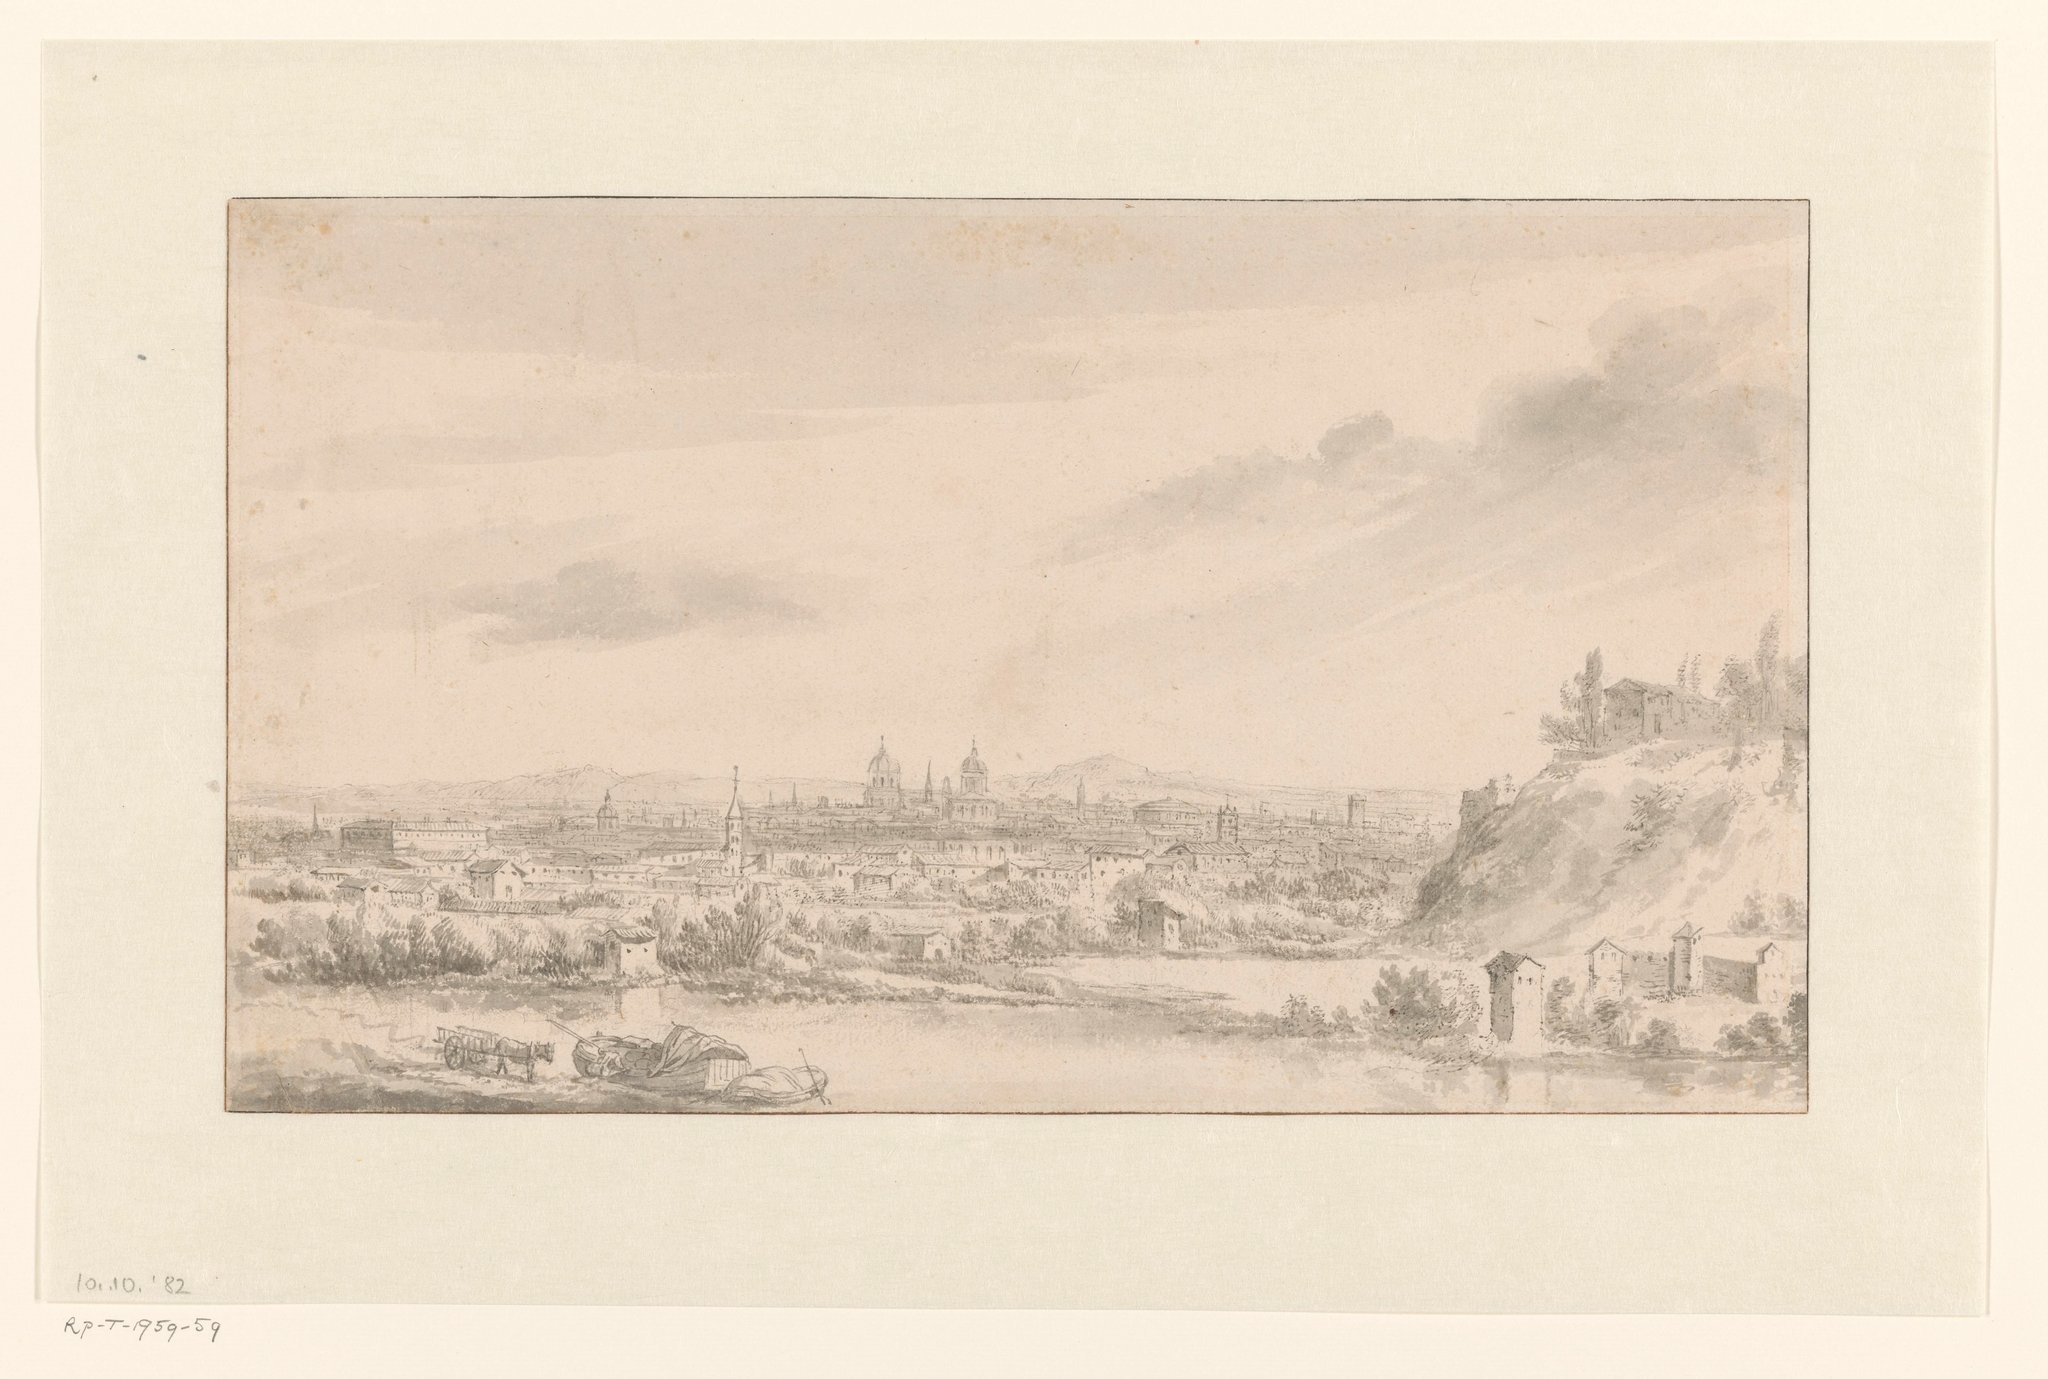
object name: drawing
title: Gezicht op Rome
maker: jacob de heusch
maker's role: draughtsman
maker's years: 1656-1701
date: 1690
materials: ink, paper, pencil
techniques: brush, pen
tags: prospect of city, town panorama, silhouette of city, rome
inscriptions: date: ‘1690’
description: Gezicht op Rome vanaf de oever van de Isola Tiberiana.